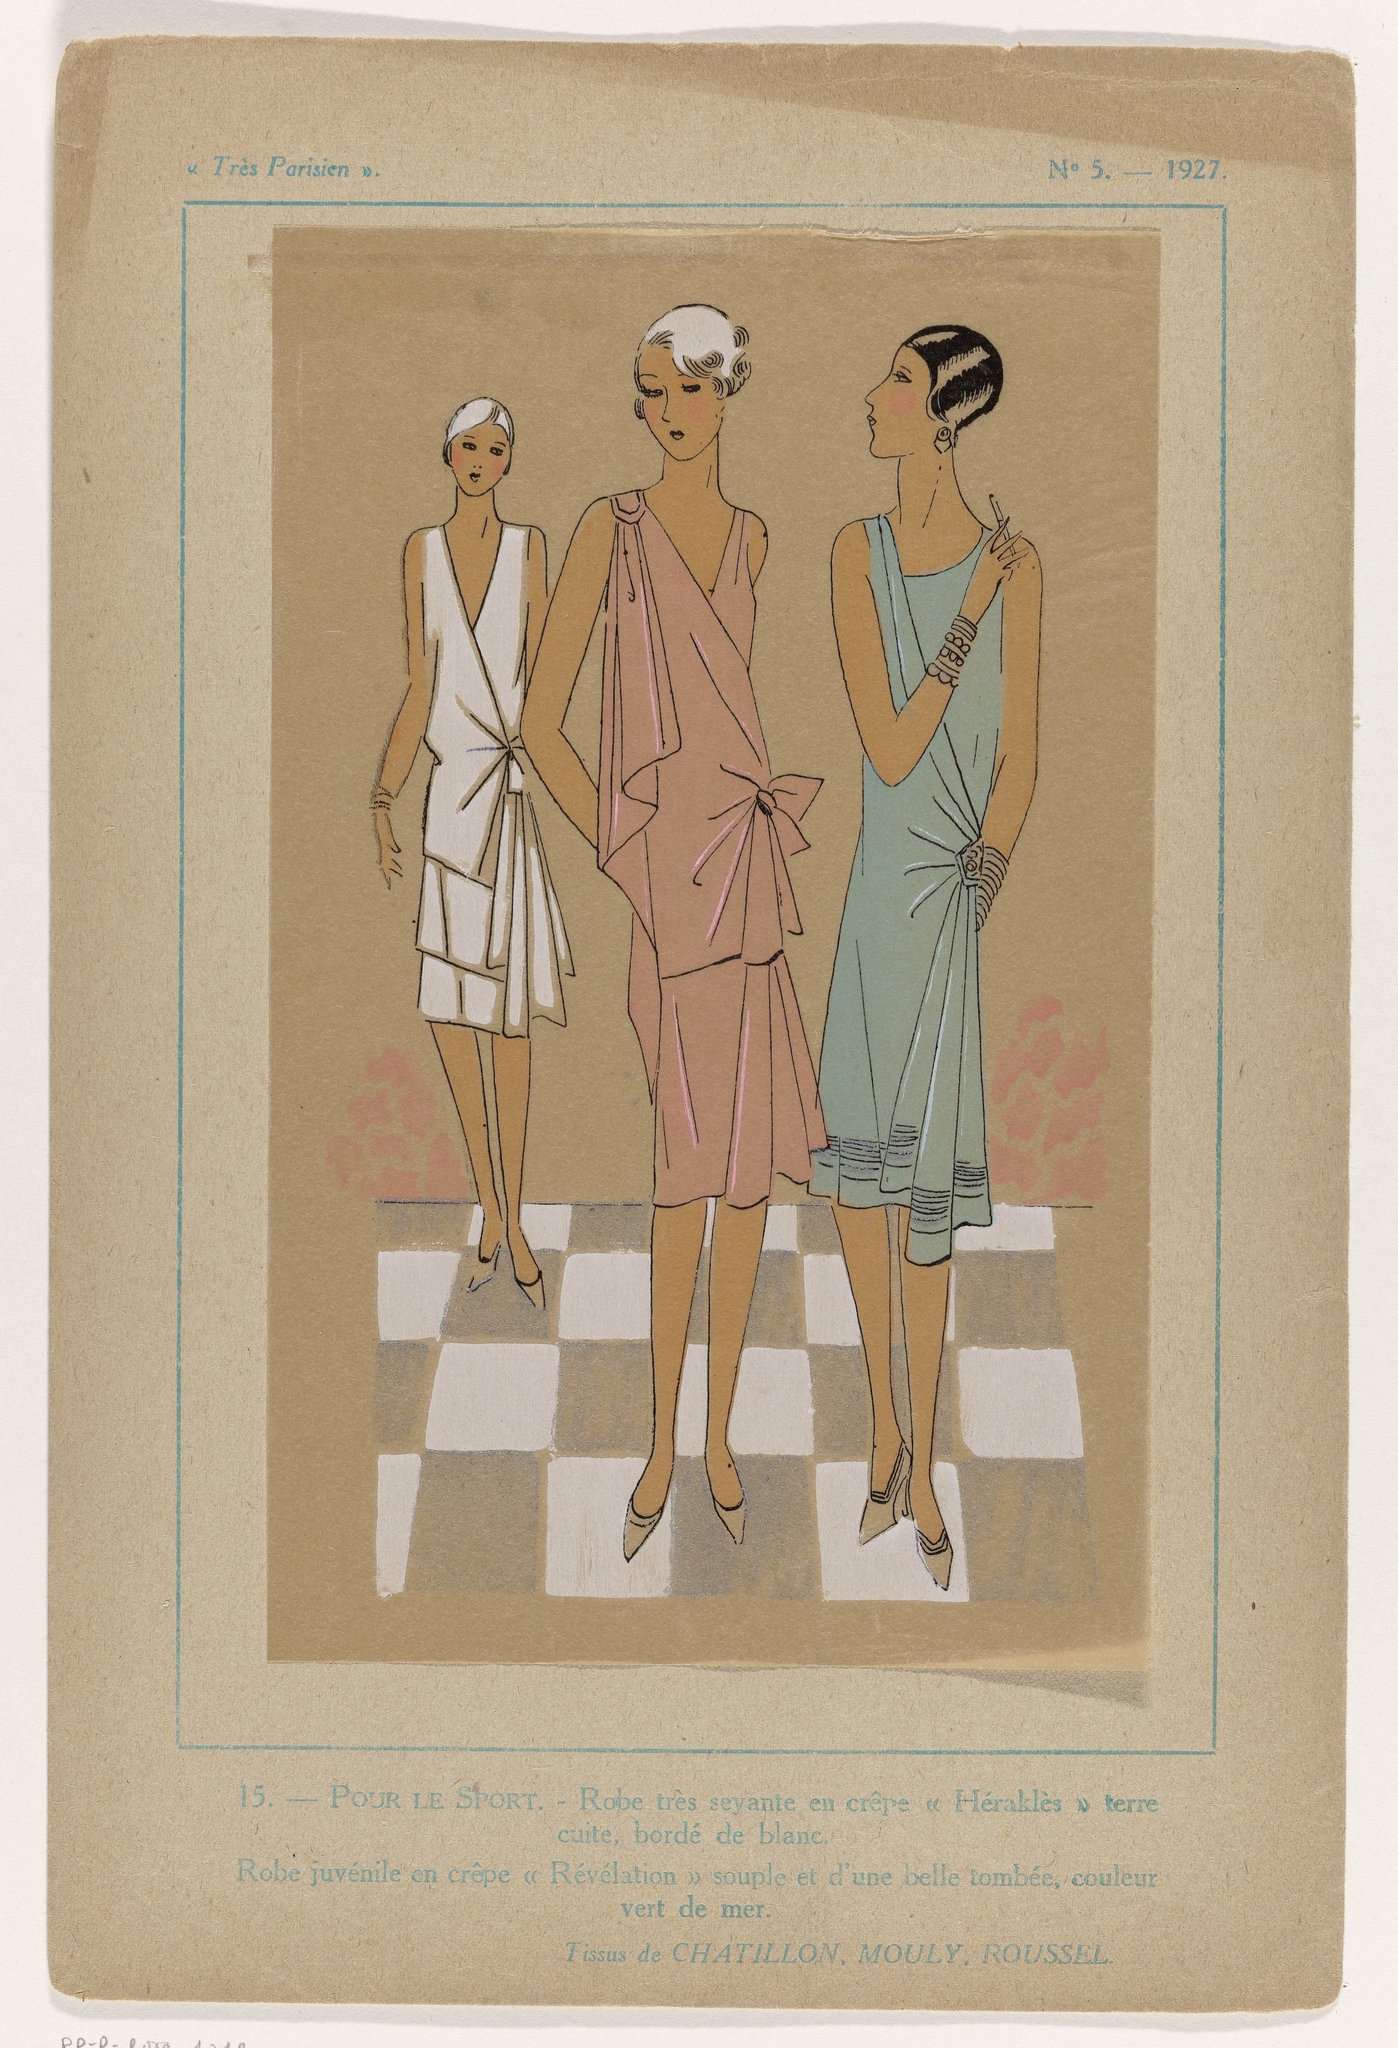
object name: fashion print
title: Très Parisien, 1927, No. 5 : -15. POUR LE SPORT (...)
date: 1927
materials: paper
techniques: hand coloring, letterpress printing, lithography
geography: paris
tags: cigarette, fashion plates, dress, gown (+ women's clothes)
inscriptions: title: ‘"Très Parisien" / No 5. - 1927.’, caption: ‘15. - POUR LE SPORT. - Robe très seyante en crêpe "Héraklès" terre cuite, bordé de blanc. Robe juvénile en crêpe " Révélation"souple et d'une belle tombée, couleur vert de mer. / Tissus de CHATILLON, MOULY, ROUSSEL.’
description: Jurk van terracottakleurige crêpe "Héraklès" afgezet met wit. Jurk van zeegroene crêpe "Révélation". Stoffen van Chatillon, Mouly, Roussel. Prent uit het modetijdschrift Très Parisien (1920-1936).